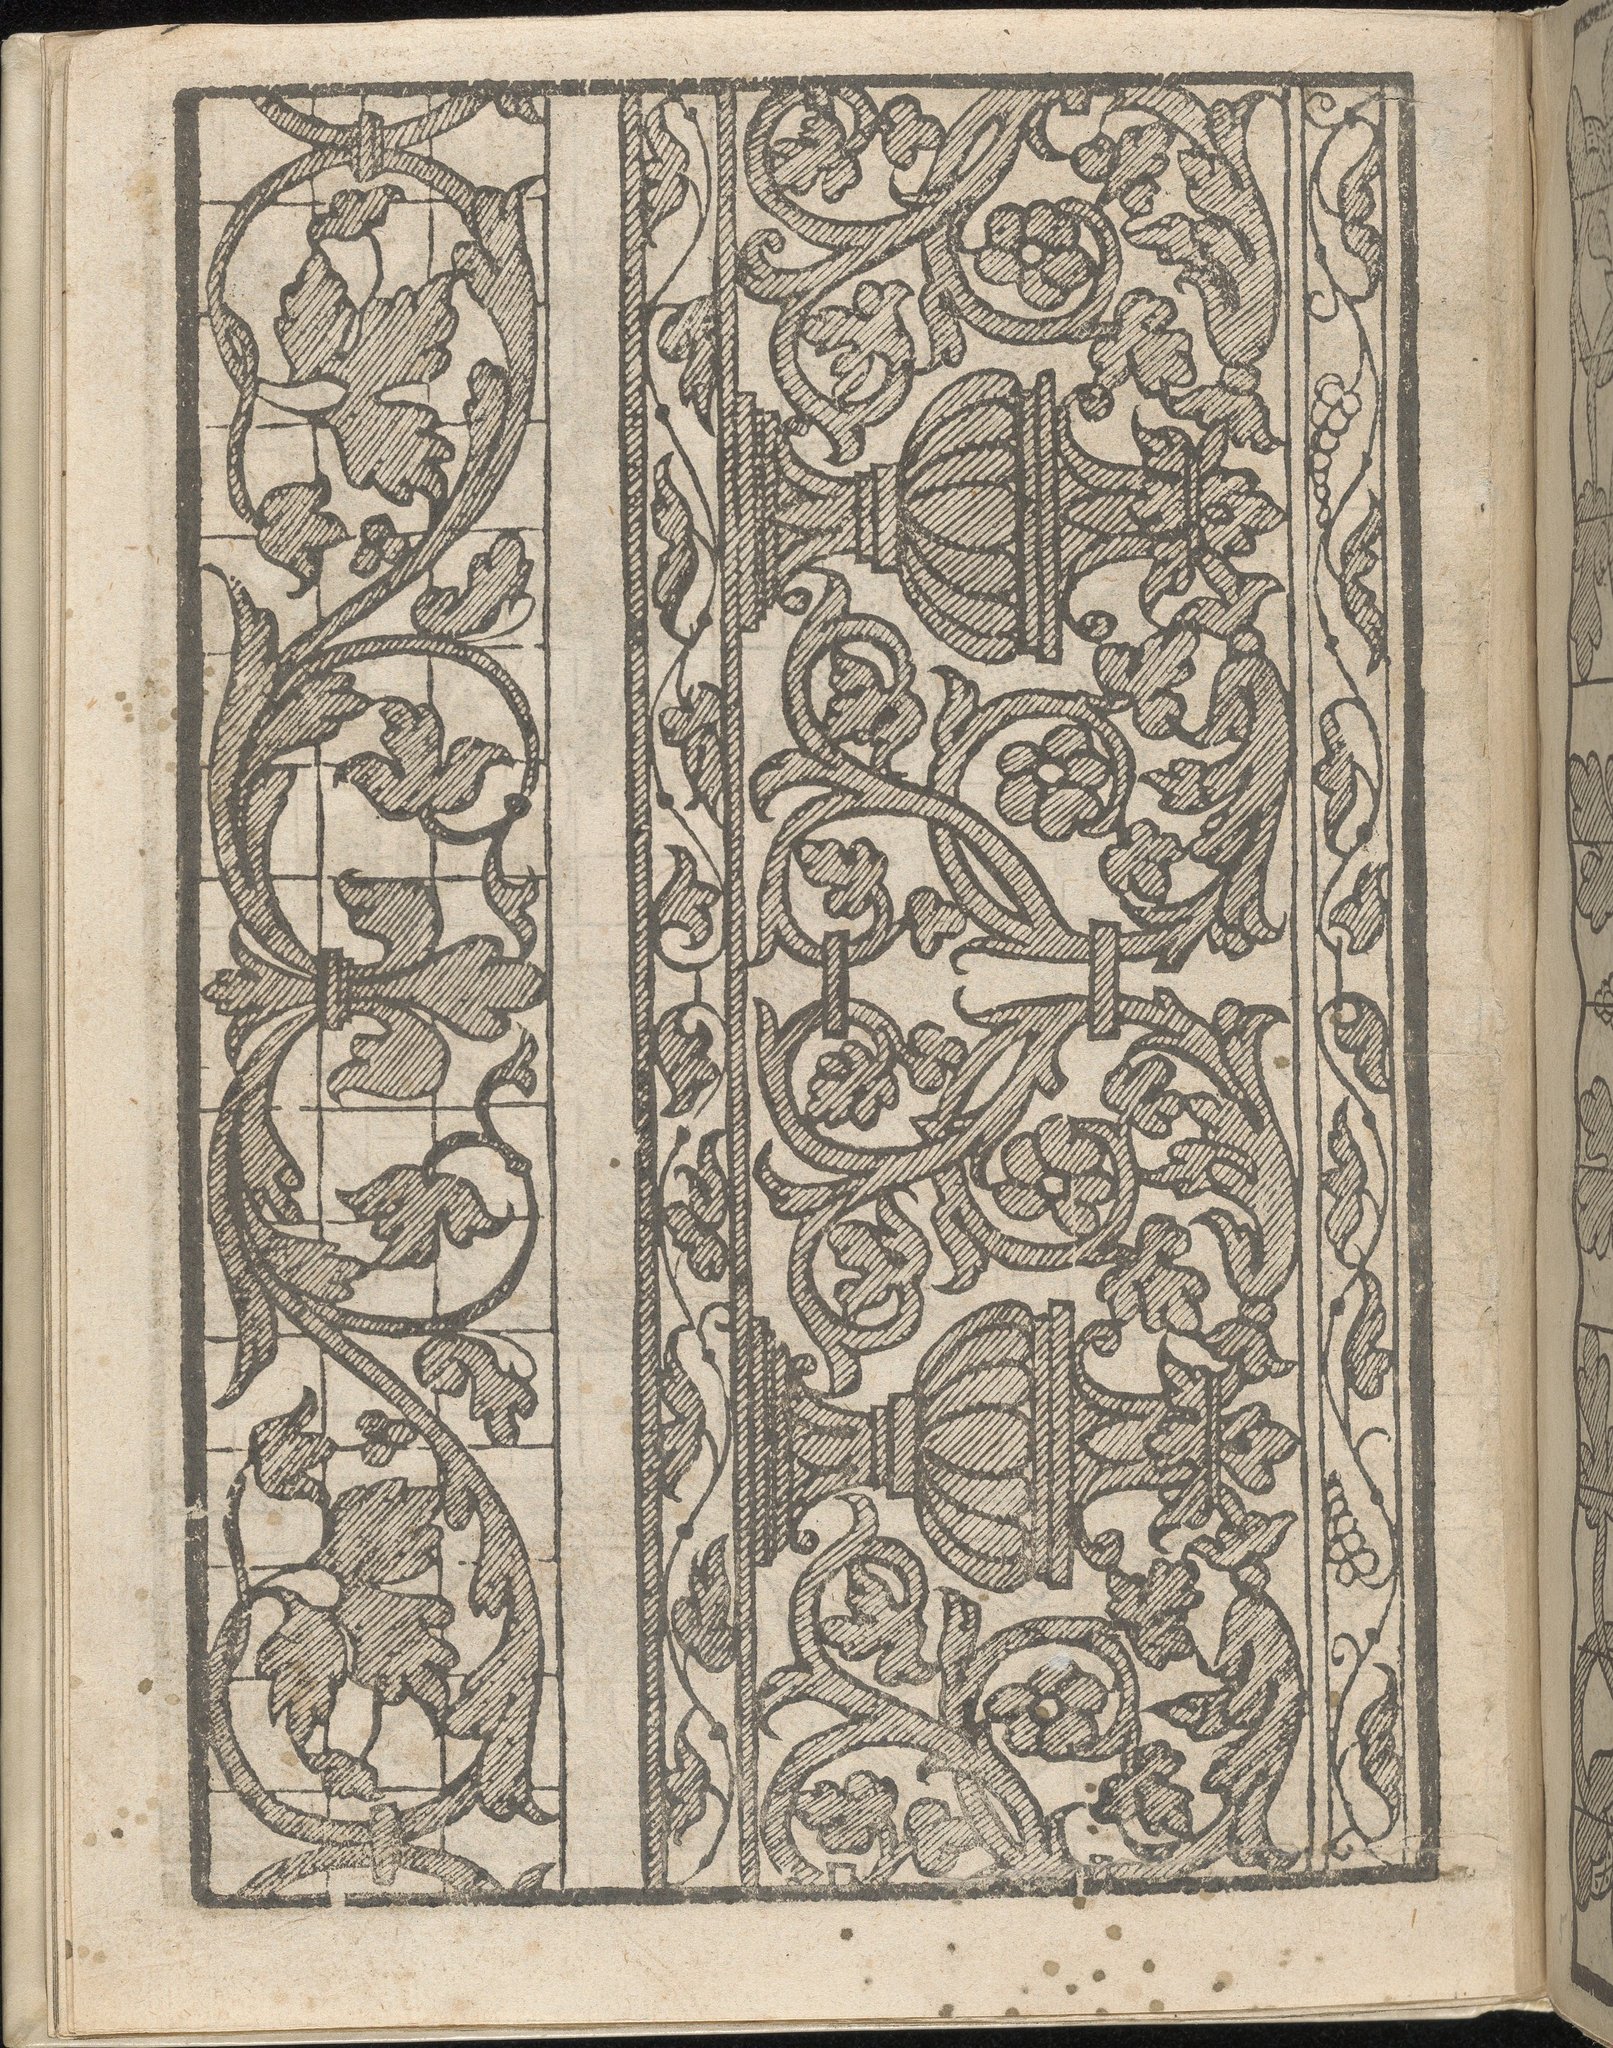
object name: book print ornament architecture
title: Lucidario di Recami, page 5 (verso)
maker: iseppo foresto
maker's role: designer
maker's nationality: italian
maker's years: 1520-1580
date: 1564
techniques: woodcut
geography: italy